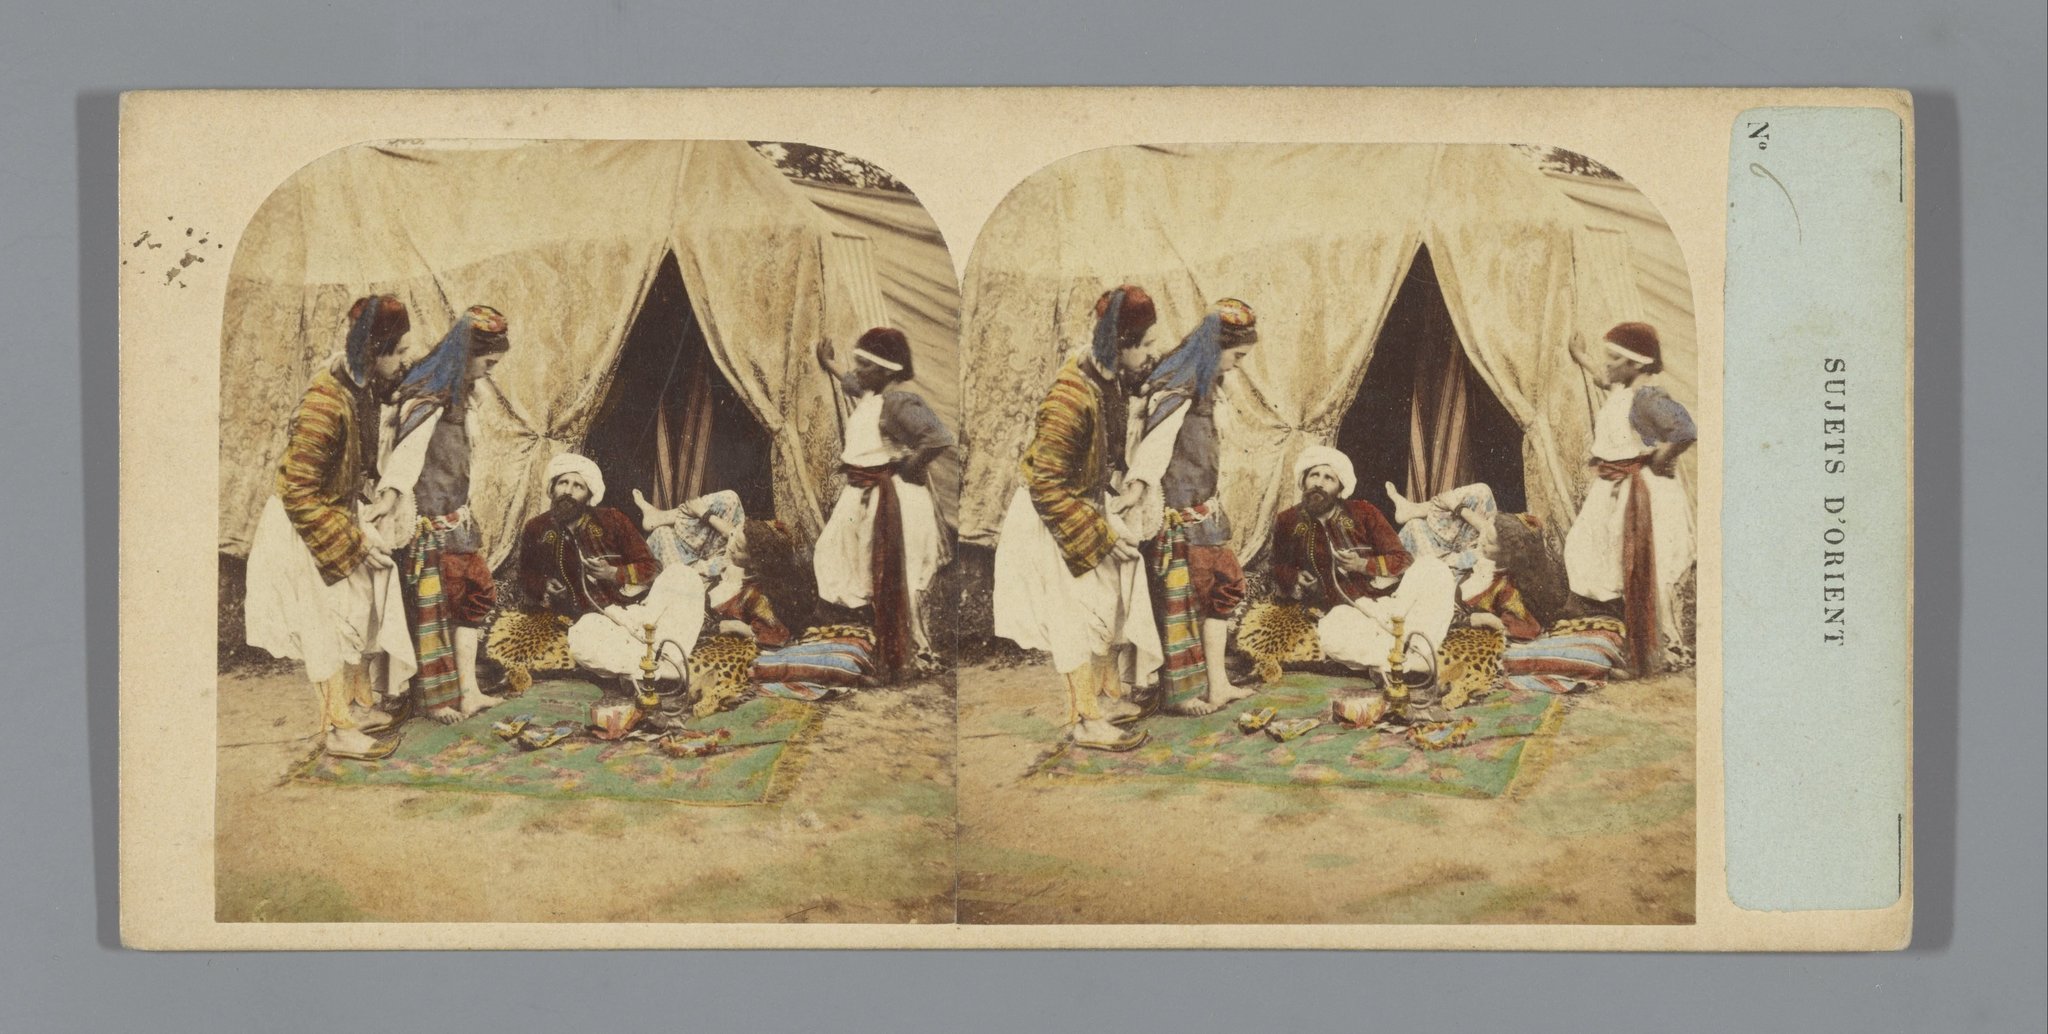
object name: stereograph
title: Oriëntaals tafereel met een groep mensen rondom een waterpijp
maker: Anonymous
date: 1852-1863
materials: cardboard, paper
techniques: albumen print, hand coloring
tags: water-pipe, hookah, narghile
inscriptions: number: ‘6’